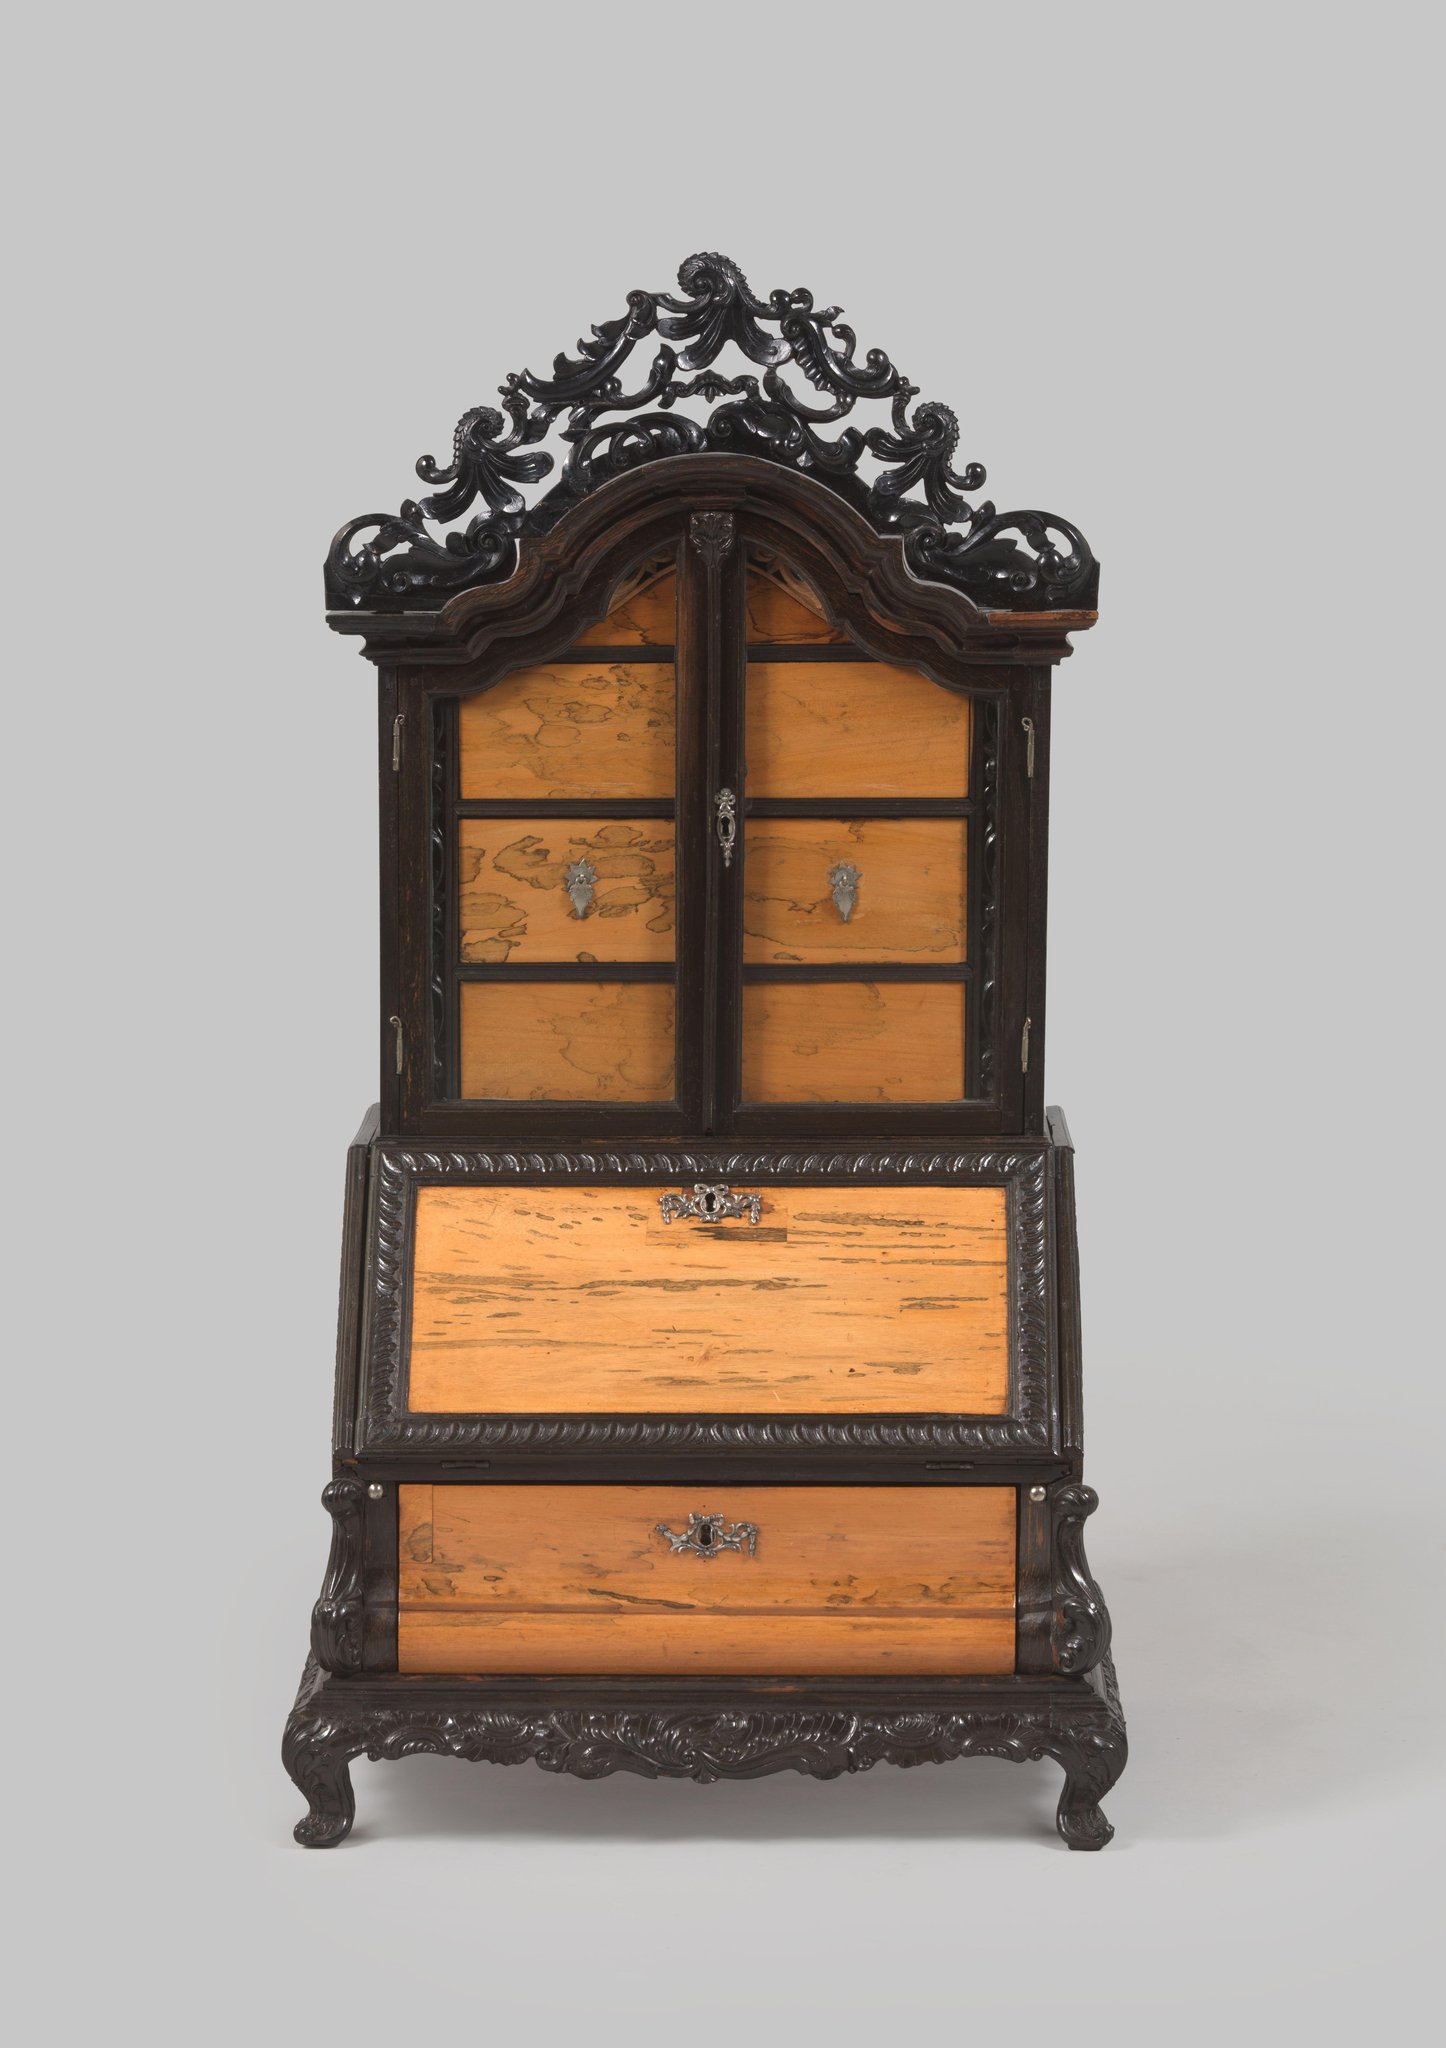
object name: desk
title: Bureau op los voetstuk met overhoeks geplaatste gebogen poten, versierd met bloem- en bladwerk, voluten en rocailles. Dubbelgebogen onderkast met lade. Bovenzijde met schuine klep met knorrenrand. Opstand met twee deuren met glazen ruiten waarachter laden. Beslag van zilver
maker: Anonymous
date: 1750-1800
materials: wood, glass, silver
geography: indonesia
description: Miniature writing cabinet. Ebony and other tropical wood. Indonesia, c. 1760 - 1780.